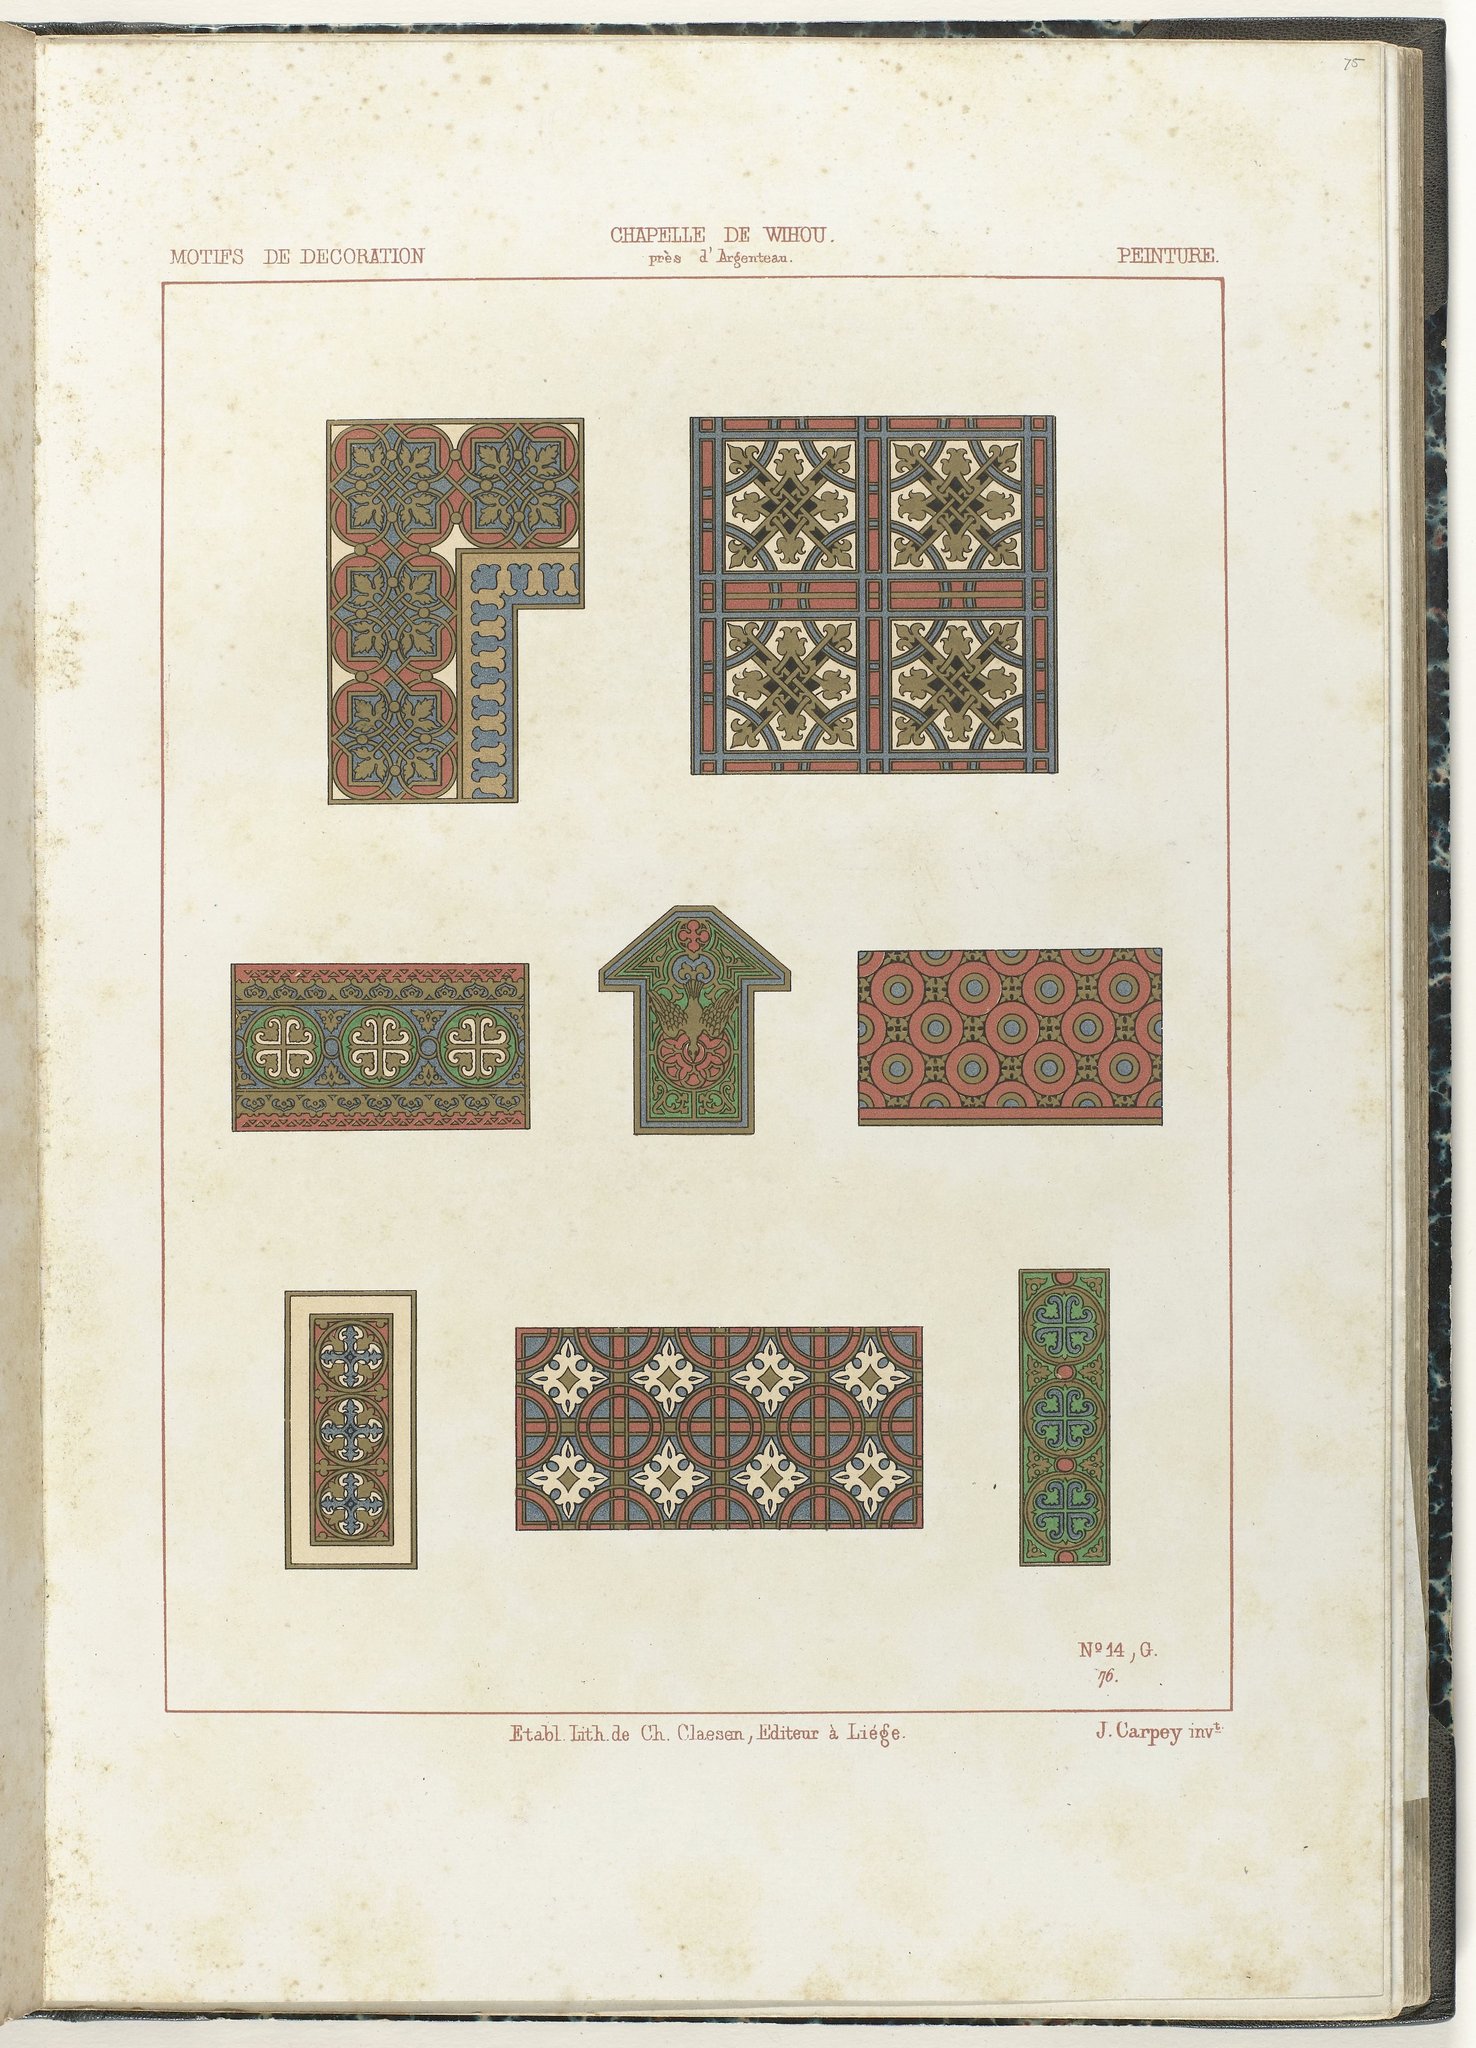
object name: print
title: Chapelle de Wihou. près d' Argenteau. / Peinture.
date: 1866-1900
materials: paper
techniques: lithograph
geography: liège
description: In het midden is een pijlvormig motief afgebeeld met een vogel die naar beneden gericht is. Linksboven staat vermeld: Motifs de Decoration, rechtsboven: Peinture, rechtsonder: N°14, G. 76.